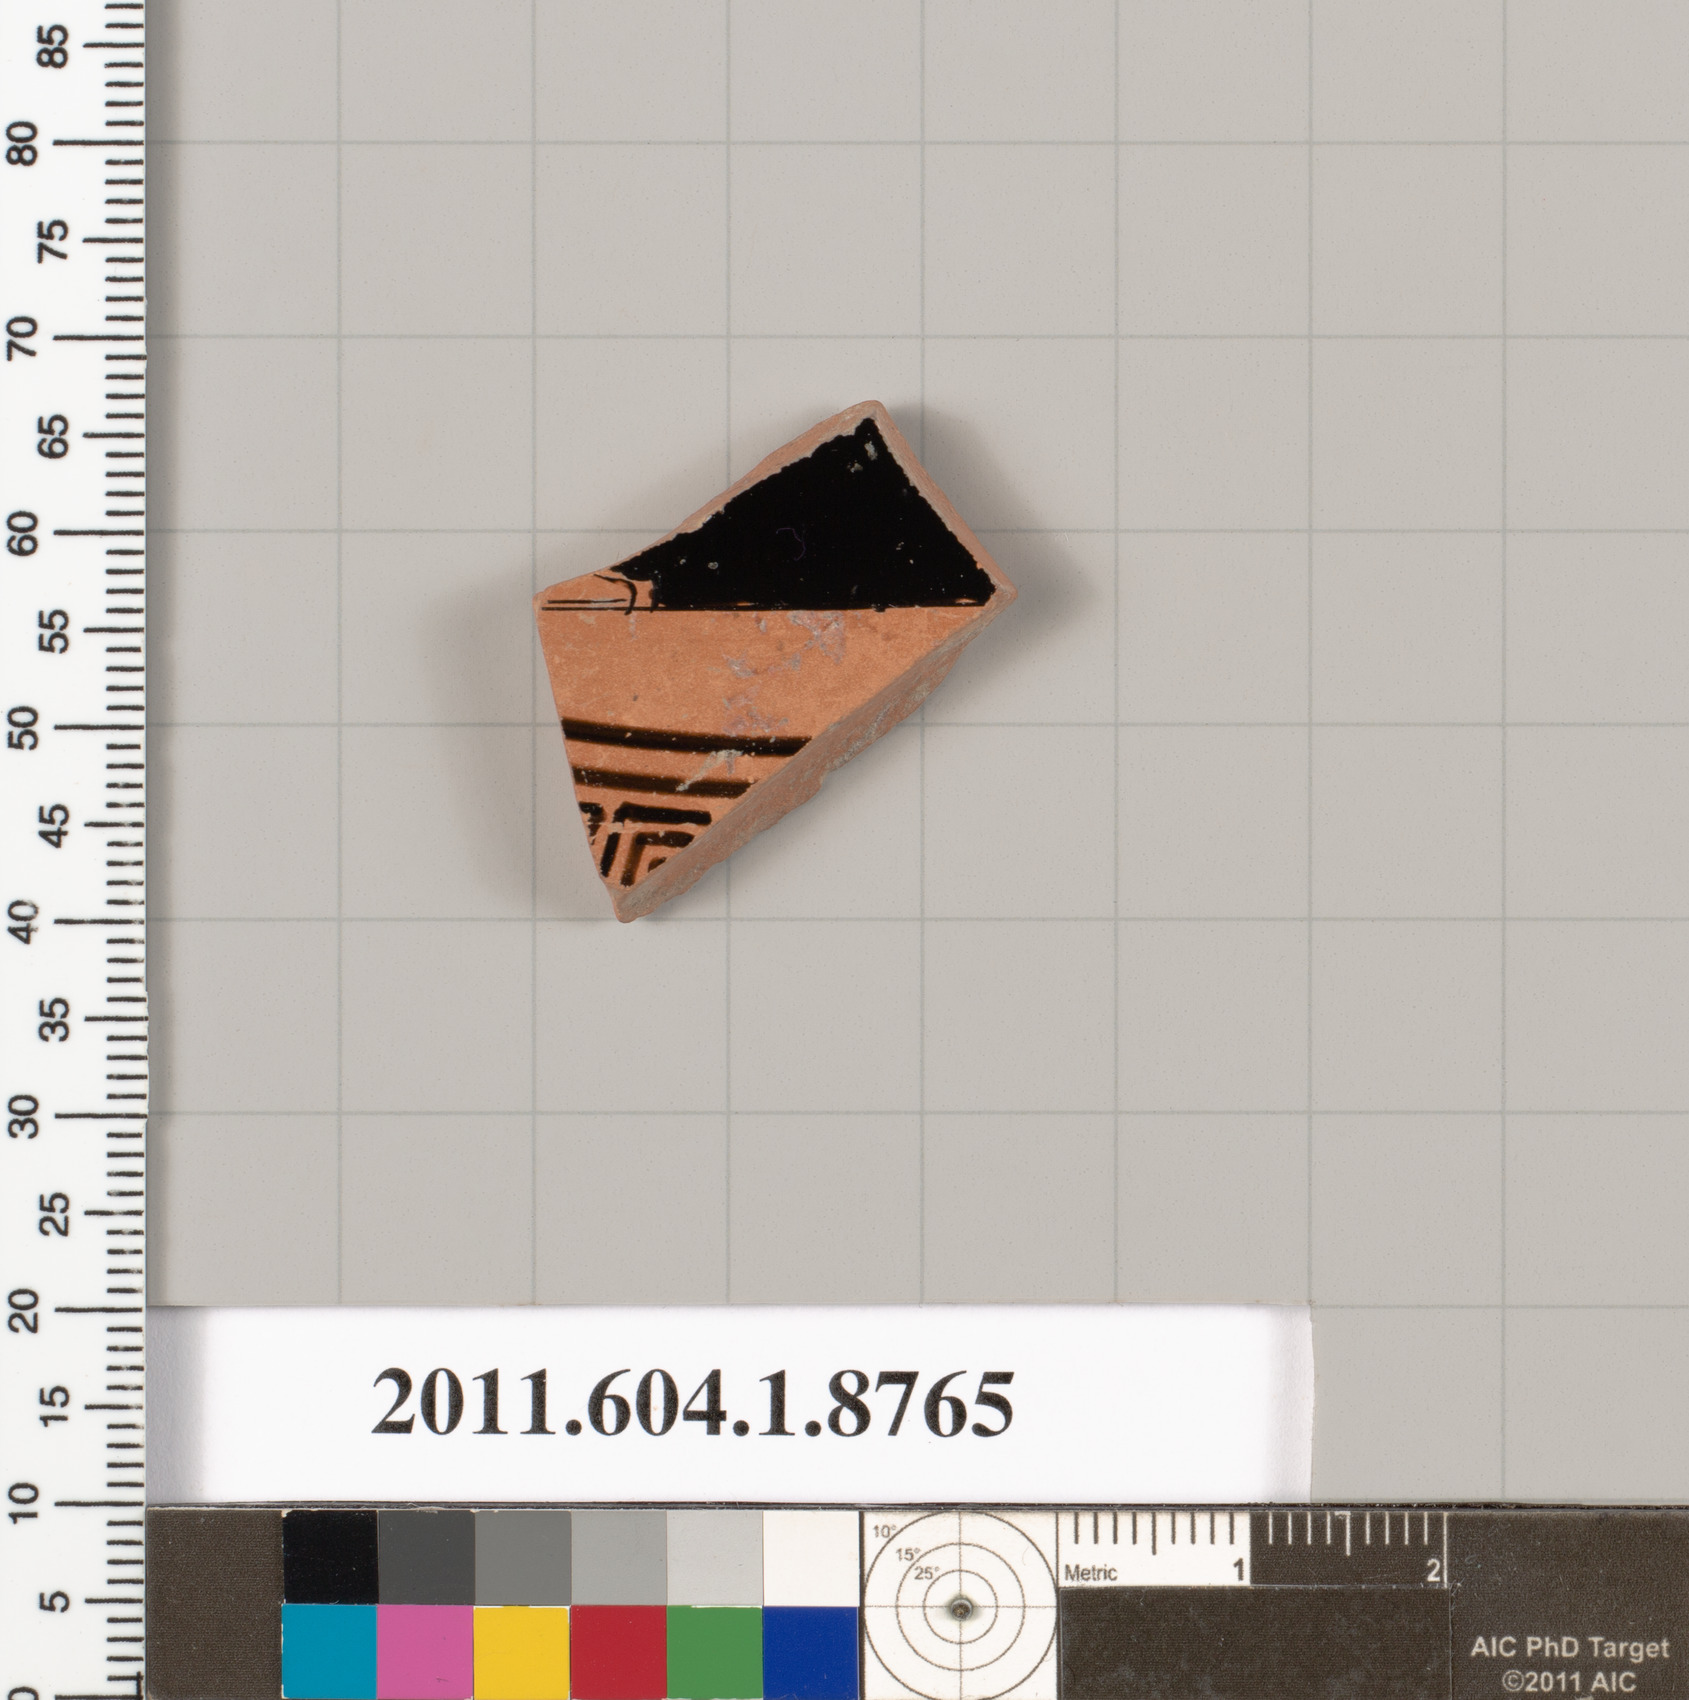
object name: kylix fragment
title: Terracotta fragment of a kylix (drinking cup)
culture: greek, attic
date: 490-470 BCE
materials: terracotta